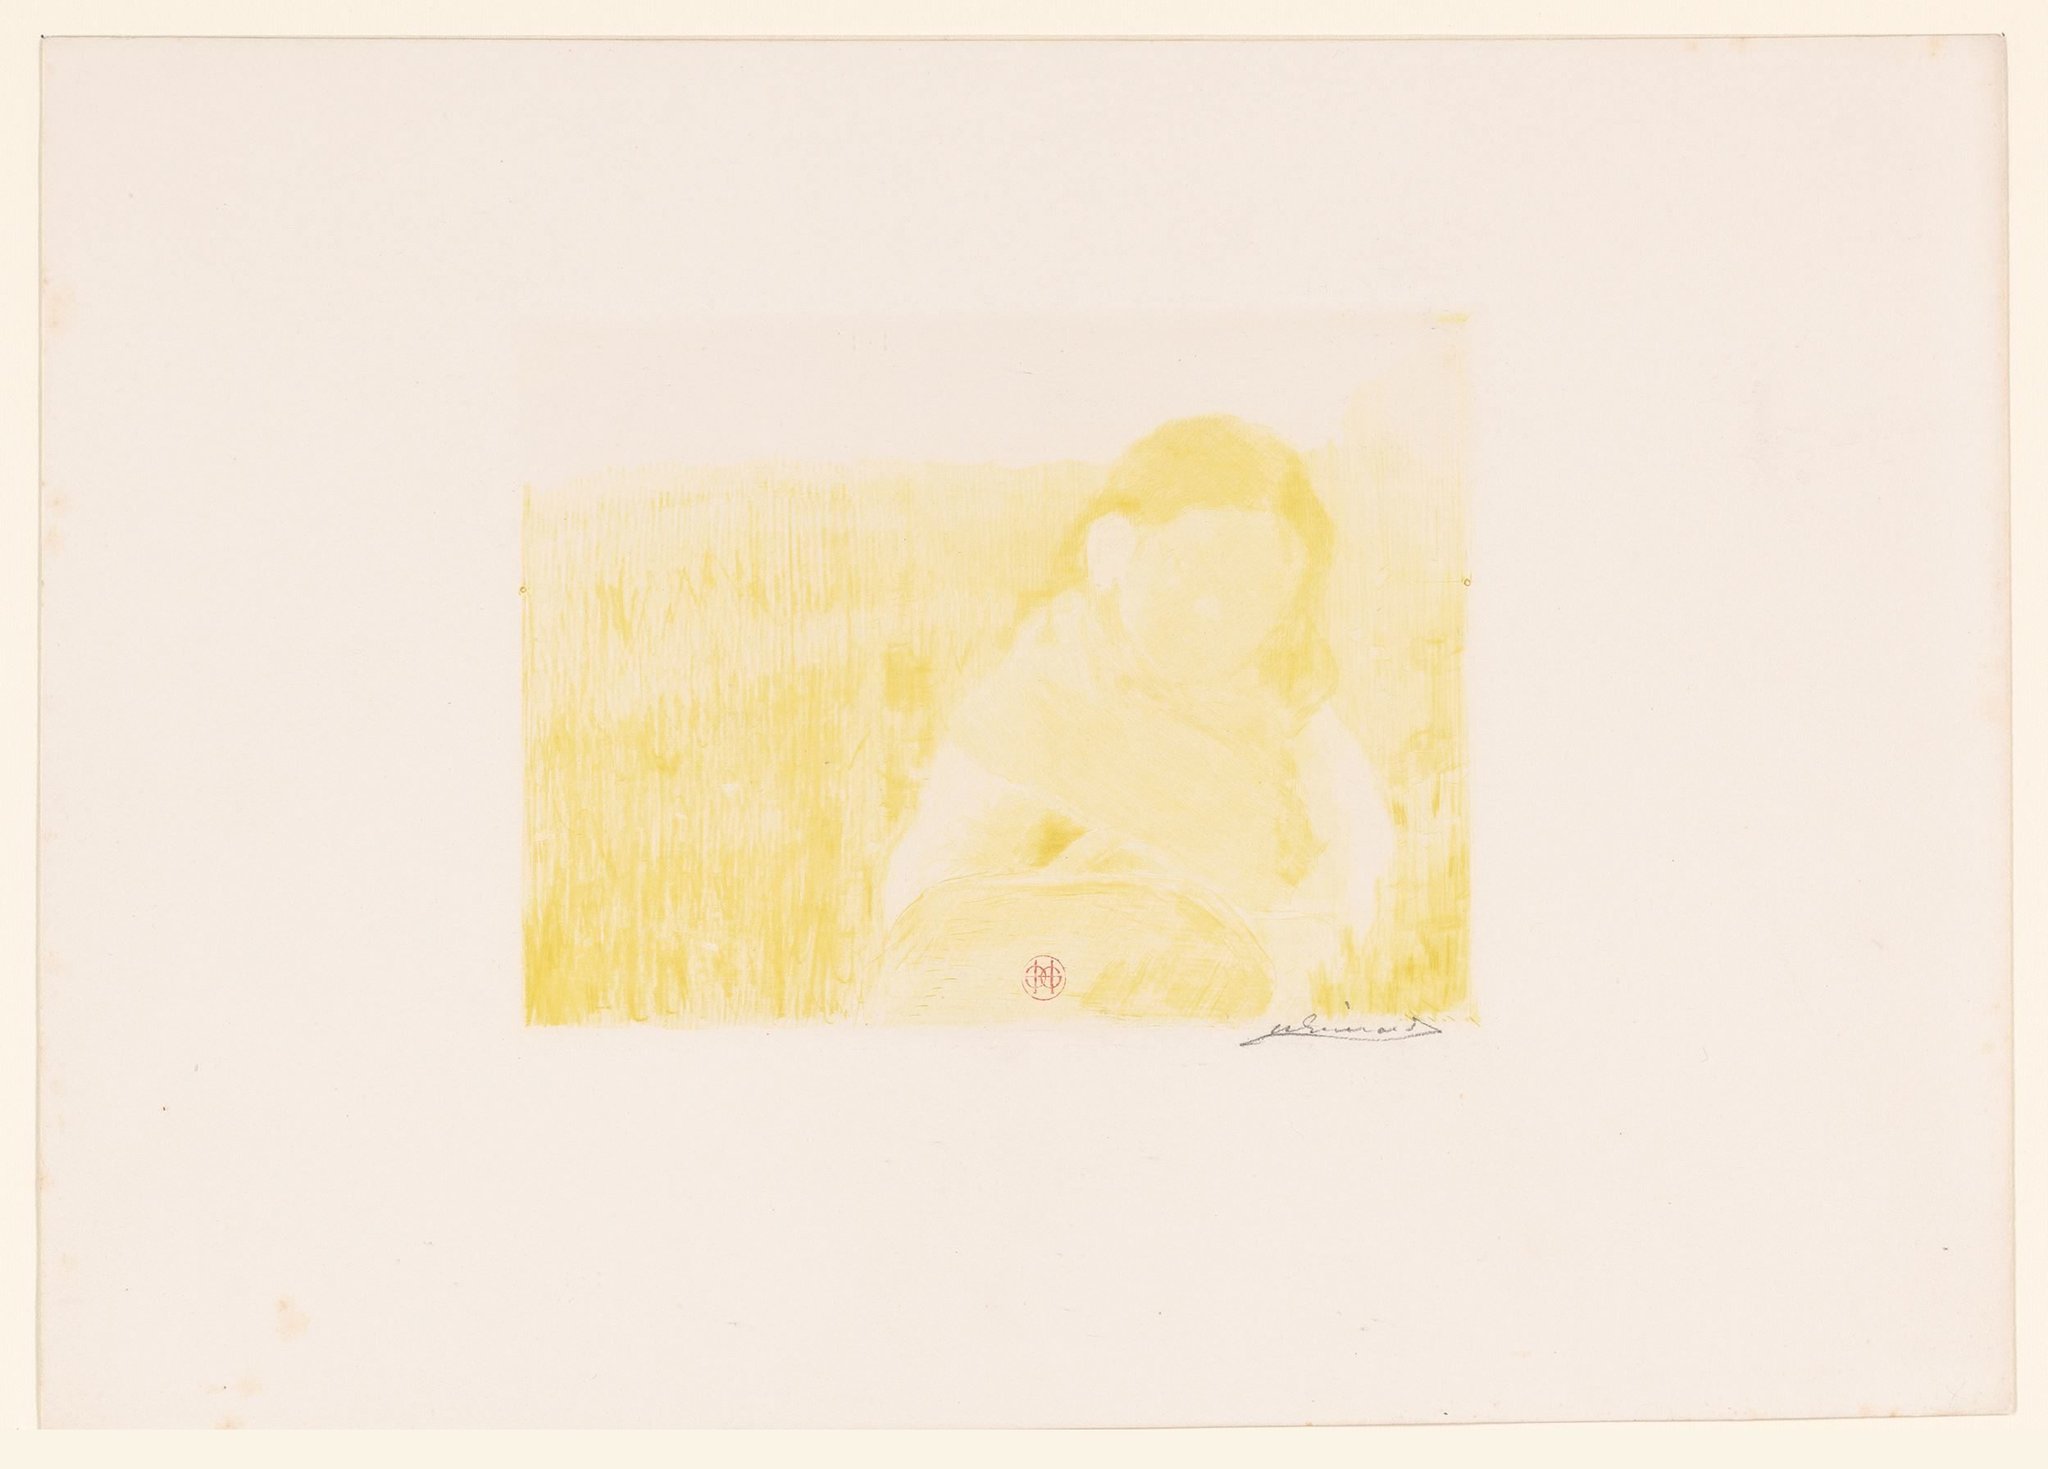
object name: print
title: Meisje met mand in een bloemenweide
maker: henri charles guérard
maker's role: print maker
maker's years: 1846-1897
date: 1856-1897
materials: paper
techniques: roulette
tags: meadow, pasture, container made of plant material other than wood: basket, girl (child between toddler and youth)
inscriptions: stamp: Lugt 1157, collector's mark: Lugt 2760, collector's mark: Lugt 2228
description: Het Rijksmuseum beschikt over negentien drukken van dezelfde voorstelling (RP-P-1972-234 t/m RP-P-1972-252) in verschillende staten en tonen.